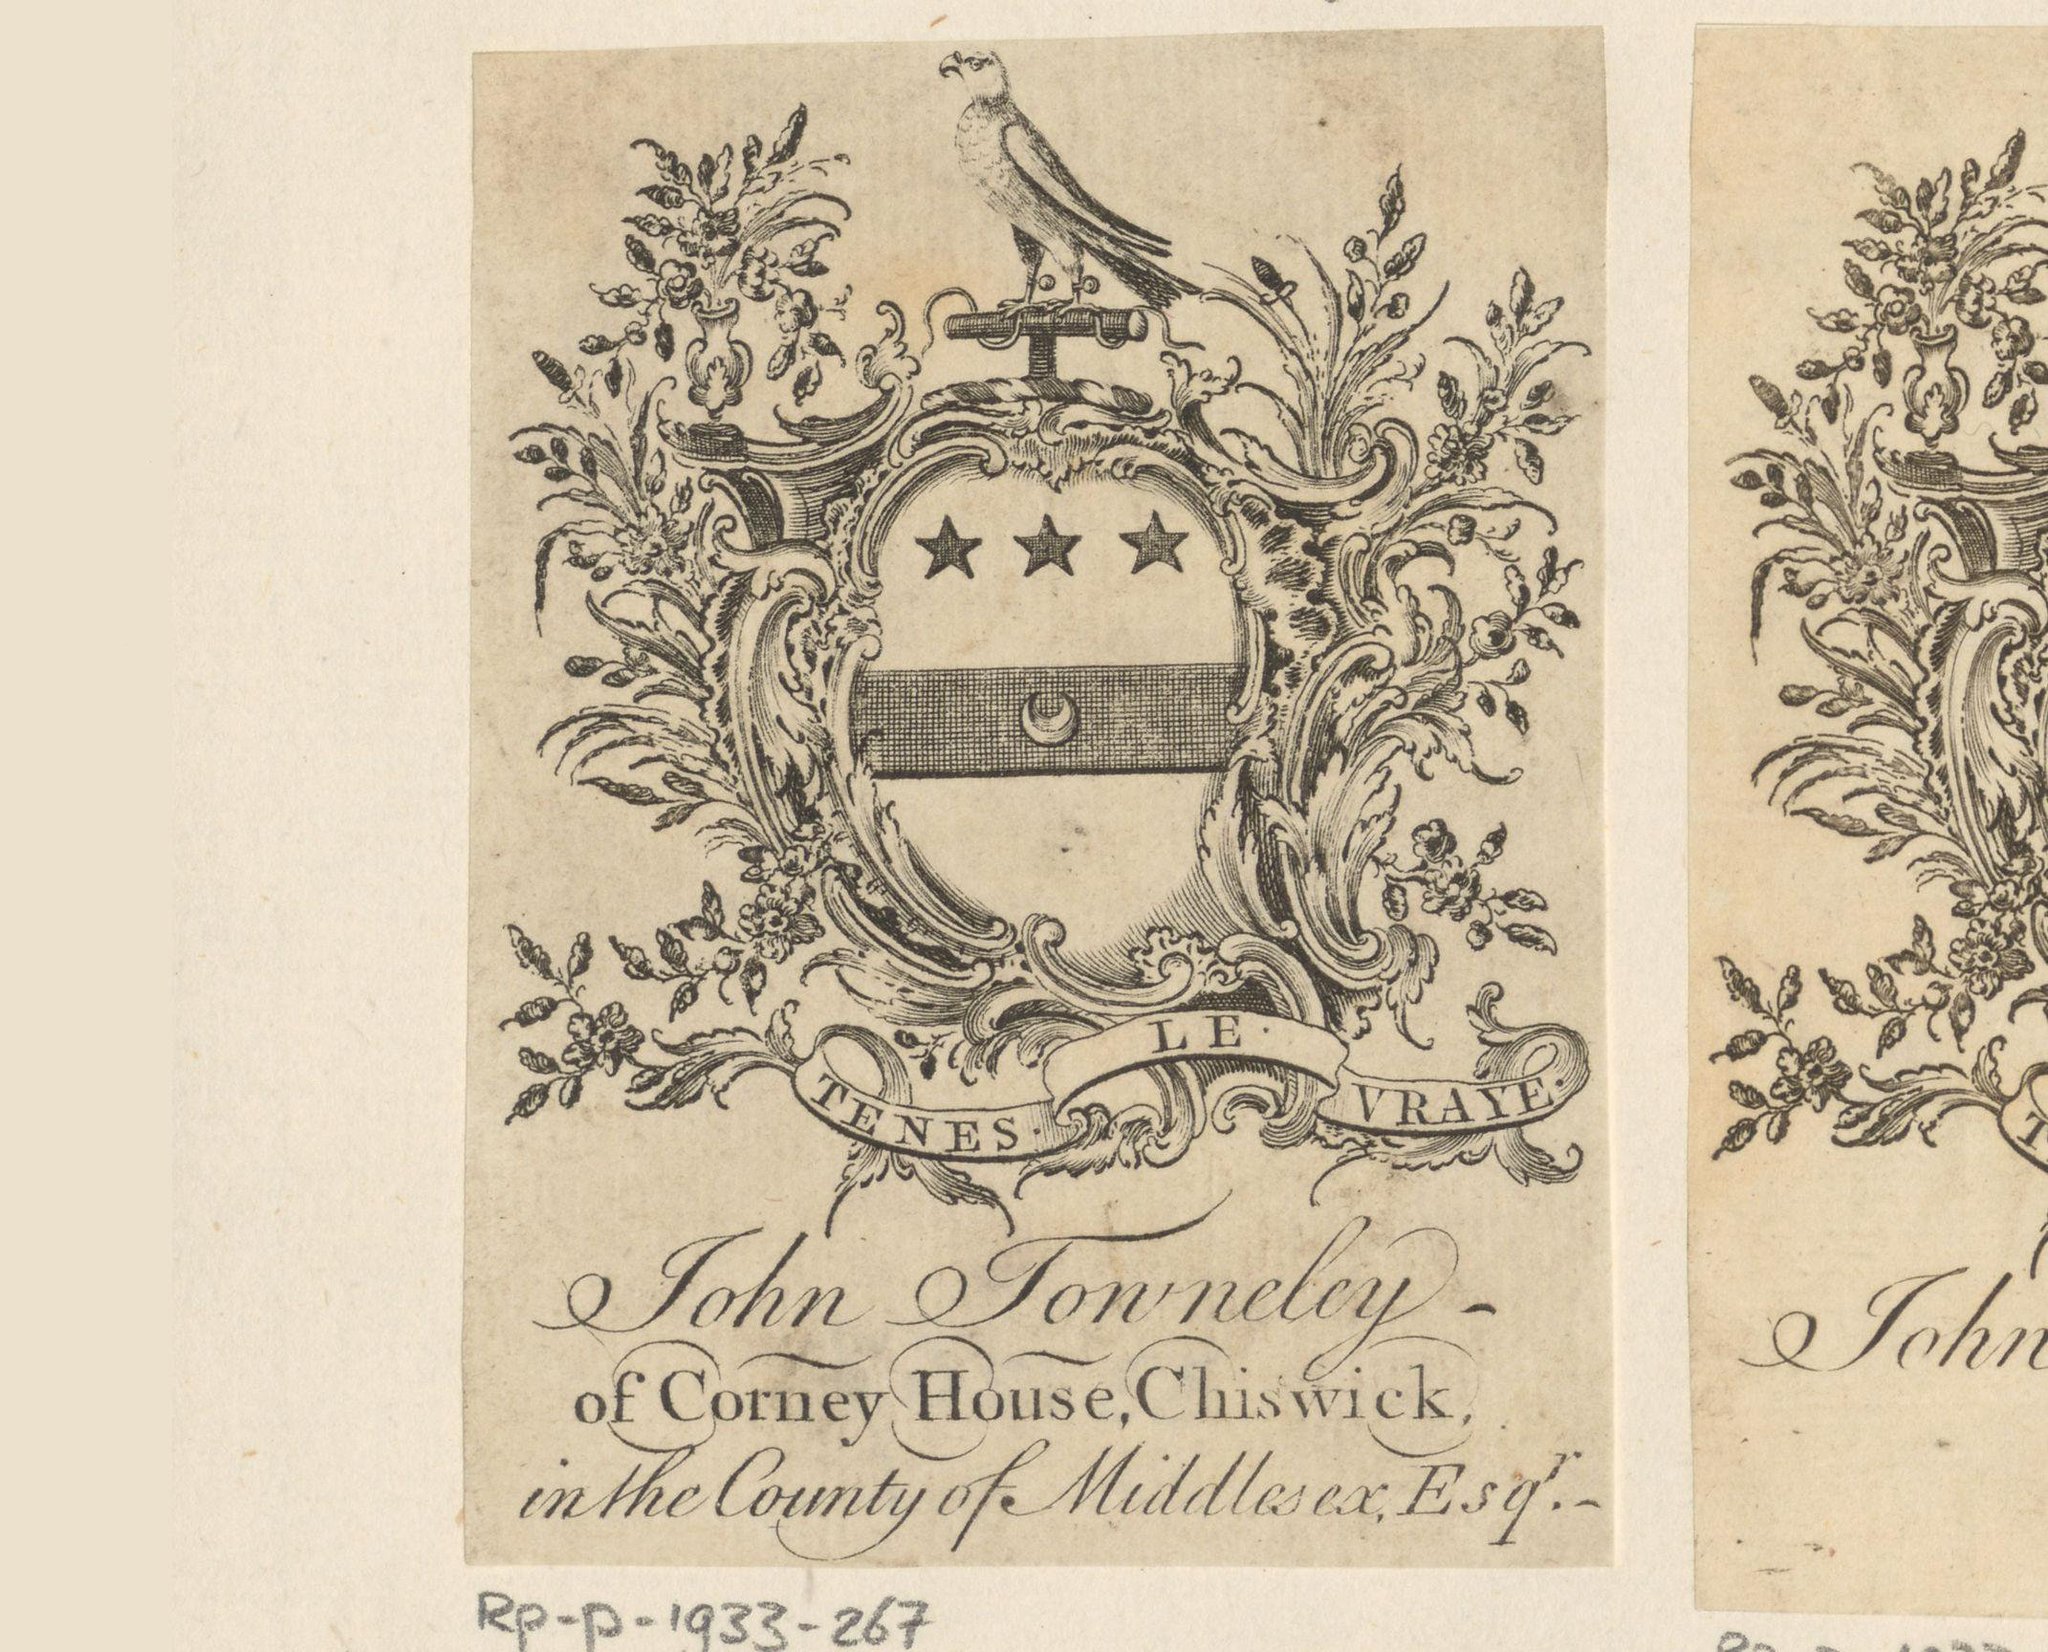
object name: bookplate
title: Ex libris van John Towneley of Corney House, Chiswick, in the County of Middlesex, Esqr.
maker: Anonymous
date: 1741-1813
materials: paper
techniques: engraving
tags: armorial bearing, heraldry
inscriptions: collector's mark: Lugt 2760